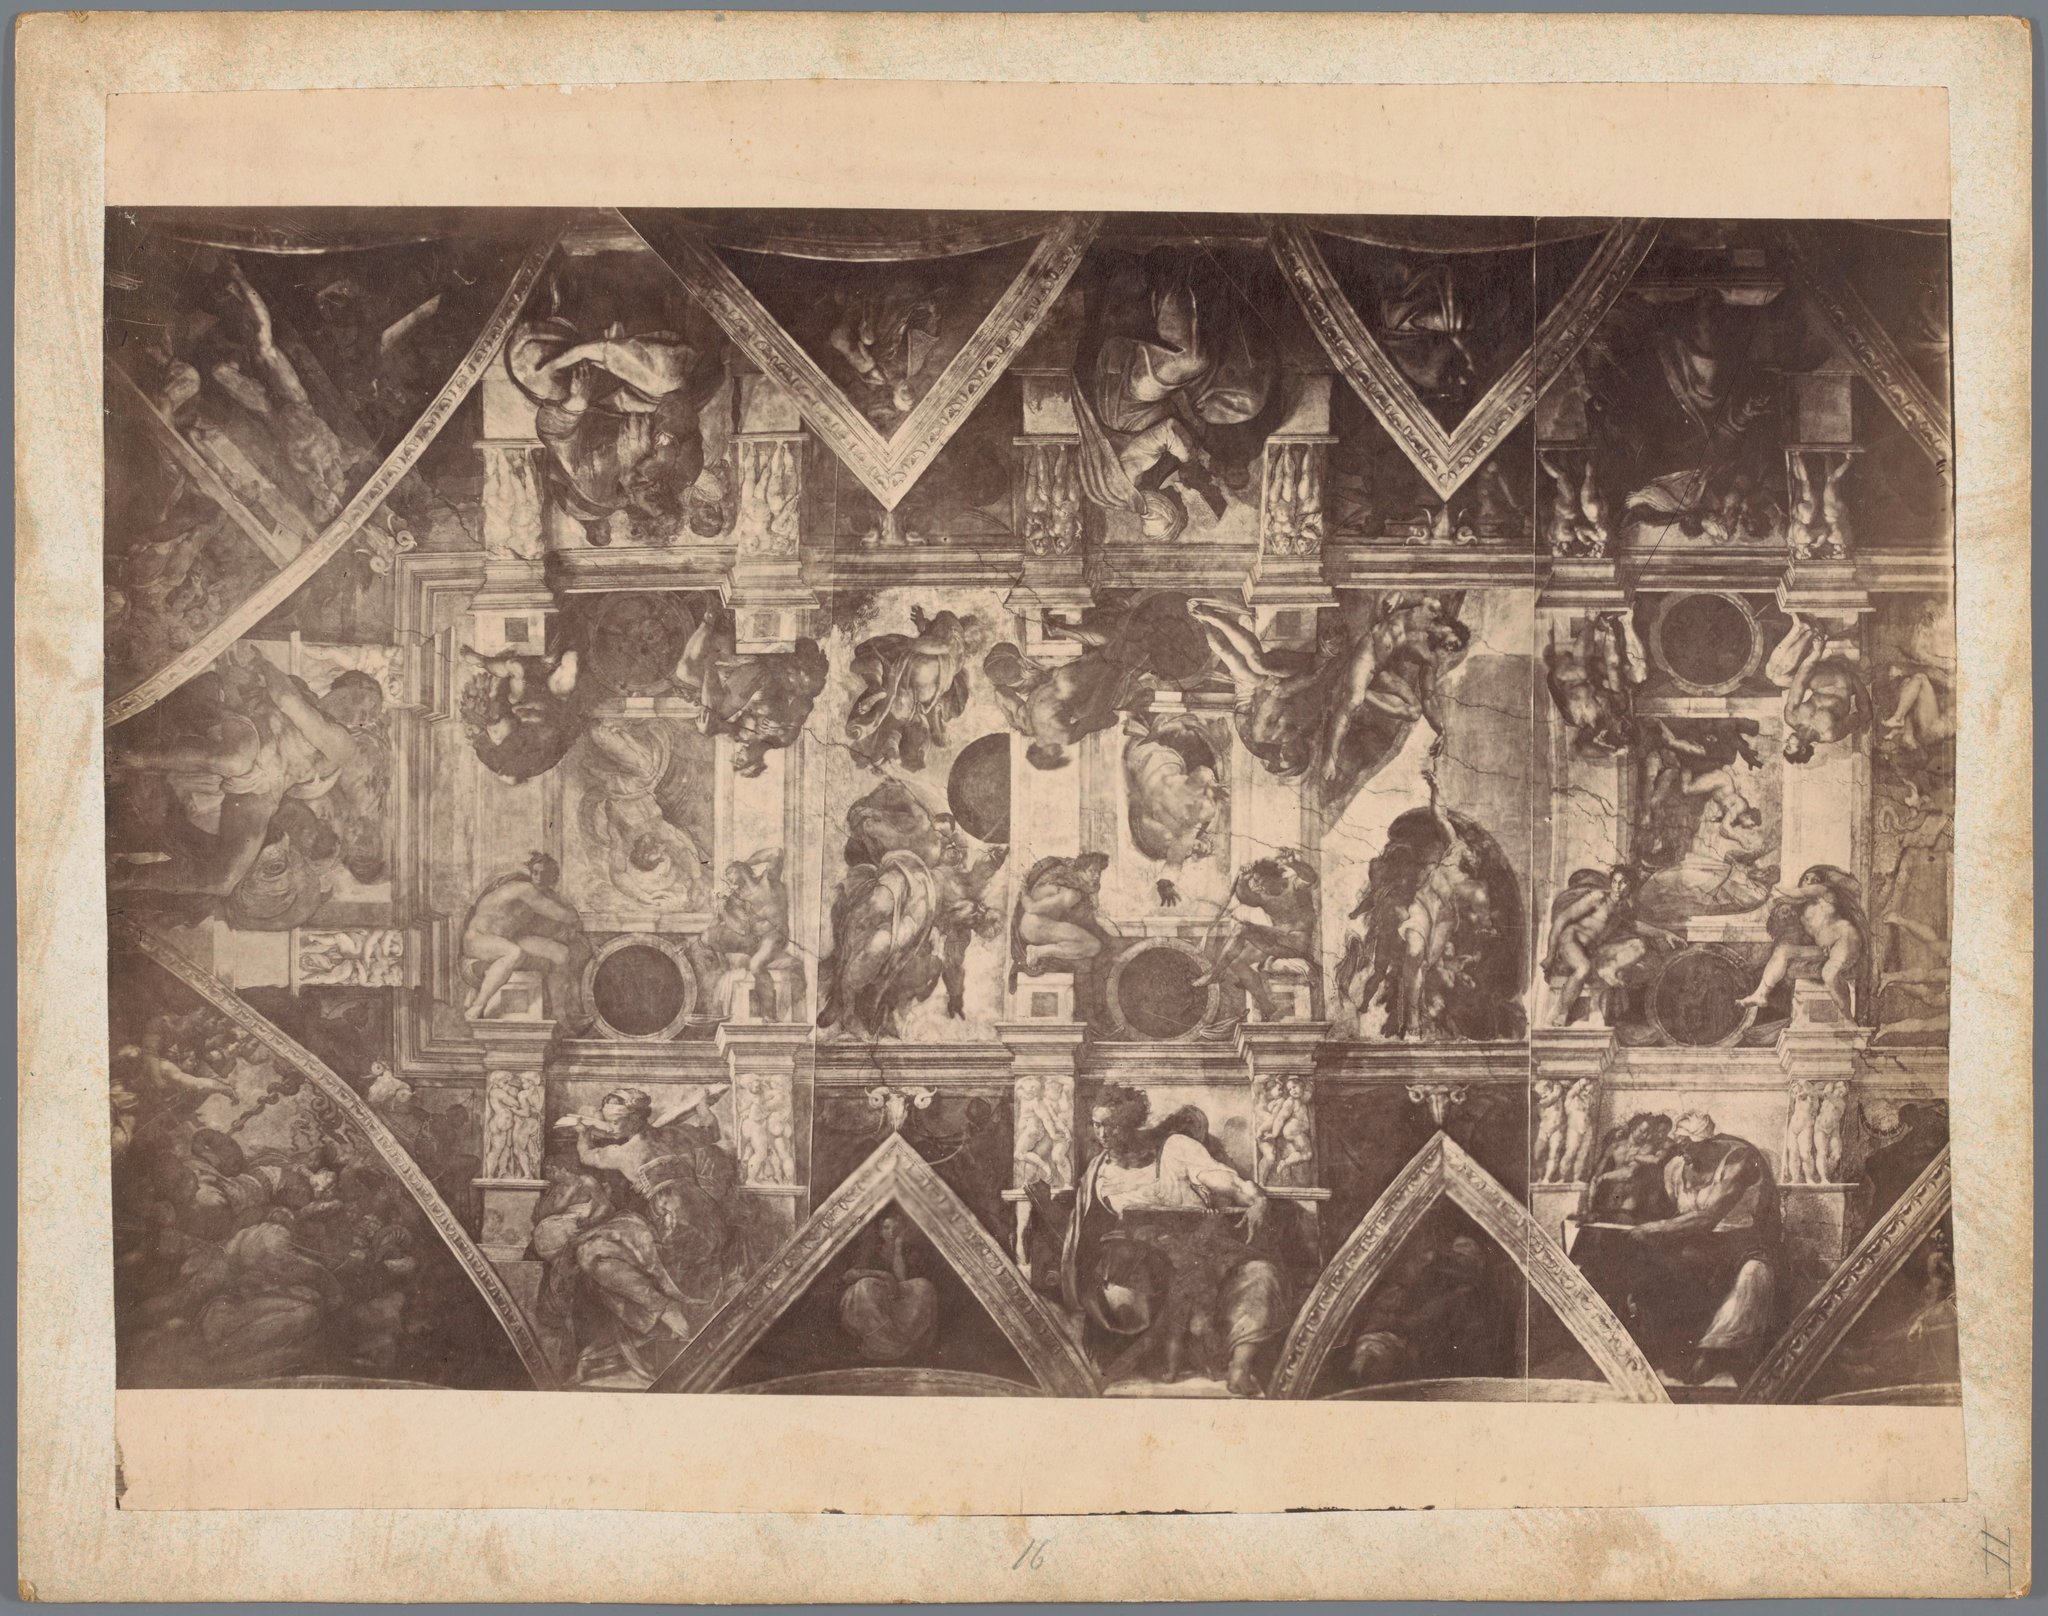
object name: photograph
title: Fotoreproductie van een deel van de fresco's op het plafond van de Sixtijnse Kapel te Vaticaanstad door Michelangelo, voorstellende de Schepping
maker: Anonymous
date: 1875-1900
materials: cardboard, photographic support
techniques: albumen print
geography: vatican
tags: genesis from the creation to the expulsion from paradise, and later years of adam and eve, sitting figure, sibyls, the man (adam) comes to life: usually god reaches out his hand or breathes life into his nostrils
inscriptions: collector's mark: Lugt 3937